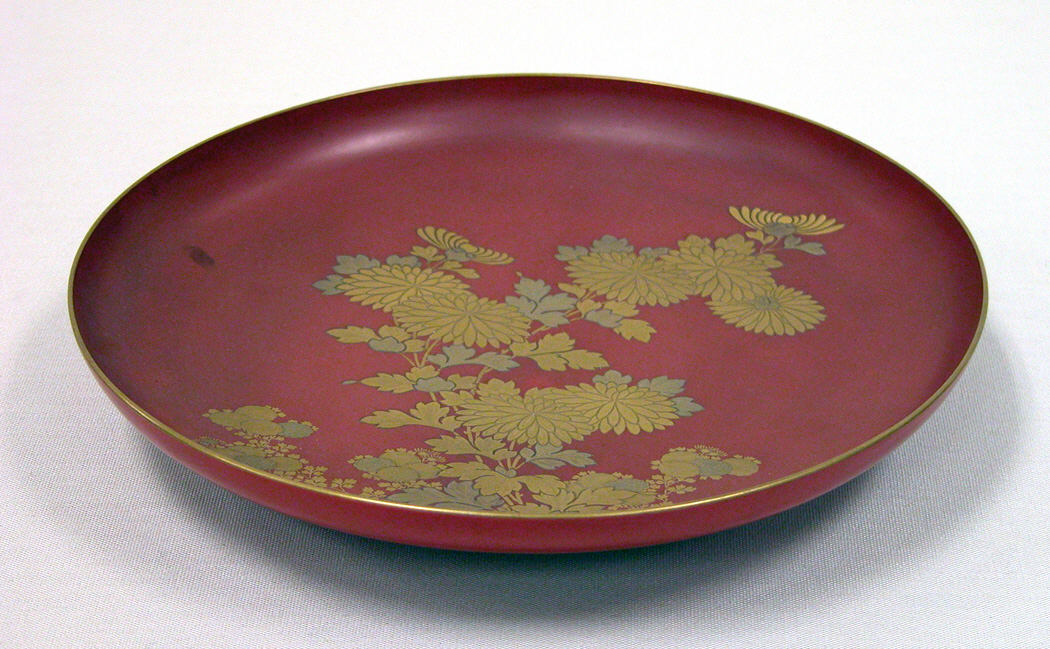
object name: wine cup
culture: japanese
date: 1834-1866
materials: gold, lacquer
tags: flowers